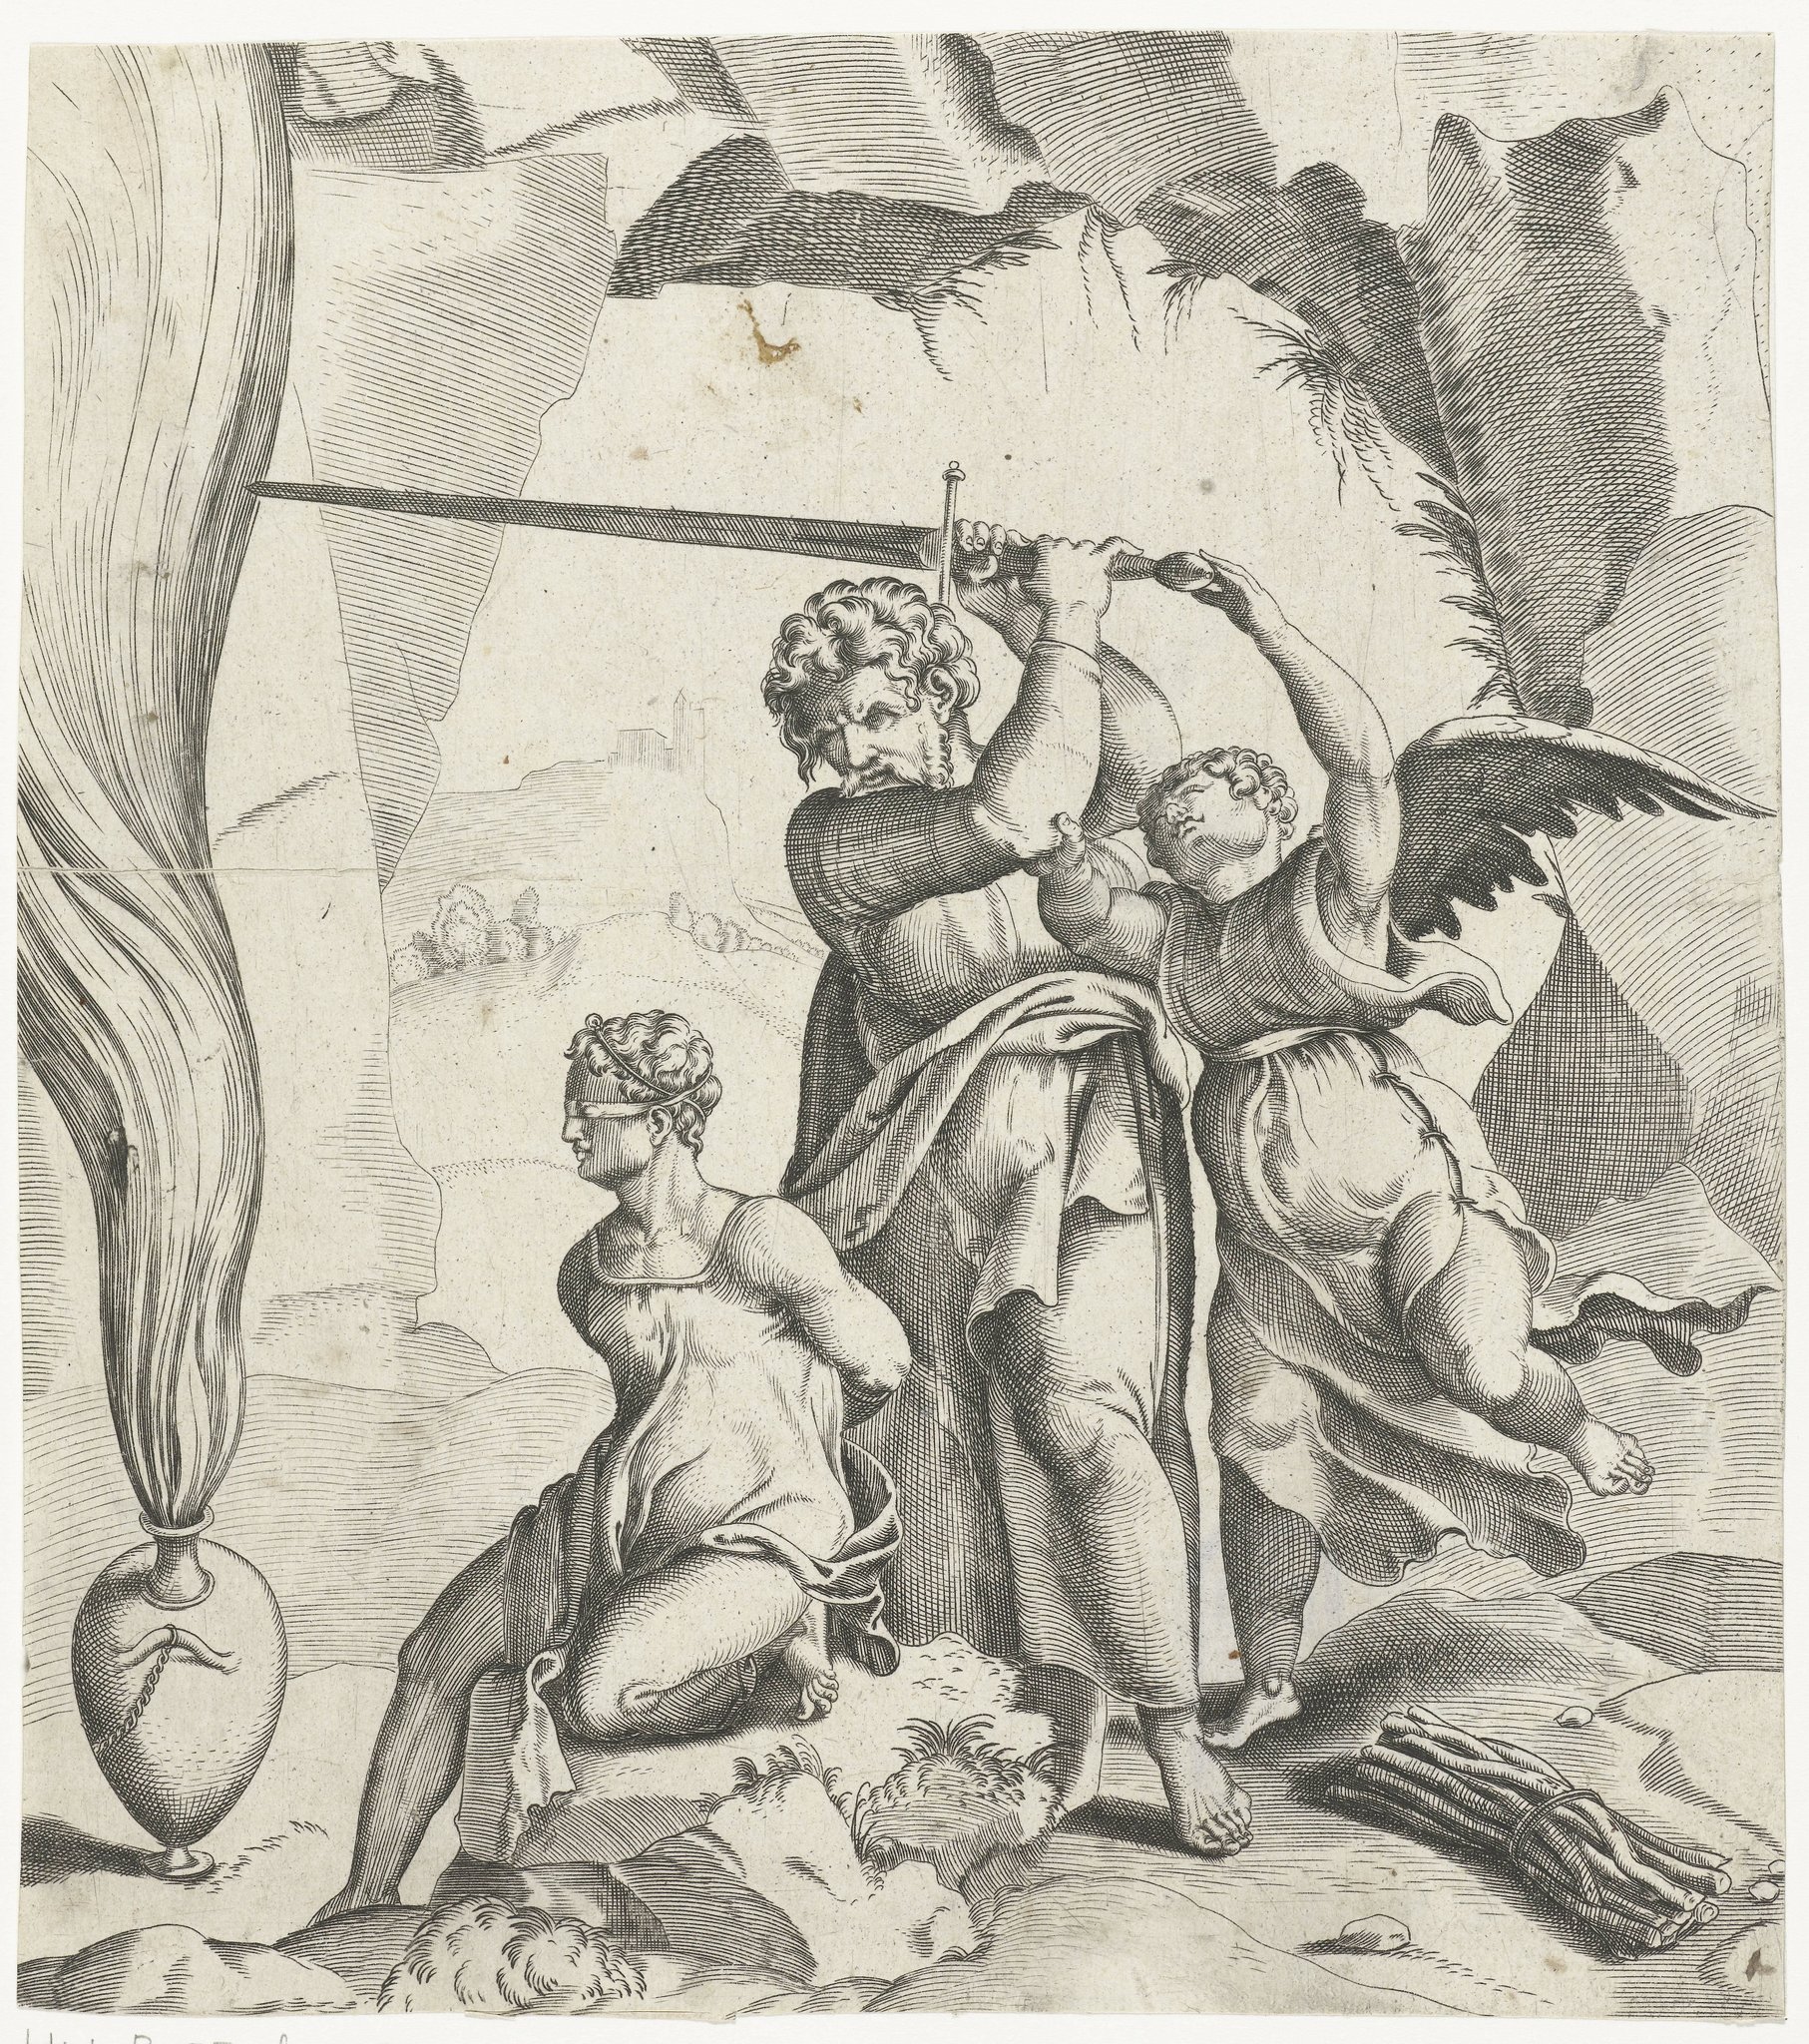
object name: print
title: Offer van Isaak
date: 1546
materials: paper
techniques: engraving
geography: nuremberg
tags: the sacrifice of isaac (genesis 22)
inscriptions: collector's mark: Lugt 10, collector's mark: Lugt 11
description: Abraham staat op het punt om zijn geliefde zoon Isaak te offeren. Een engel houdt hem tegen. In tegenstelling tot de beeldtraditie speelt zich de scène in een soort grot af in plaats van op een berg.